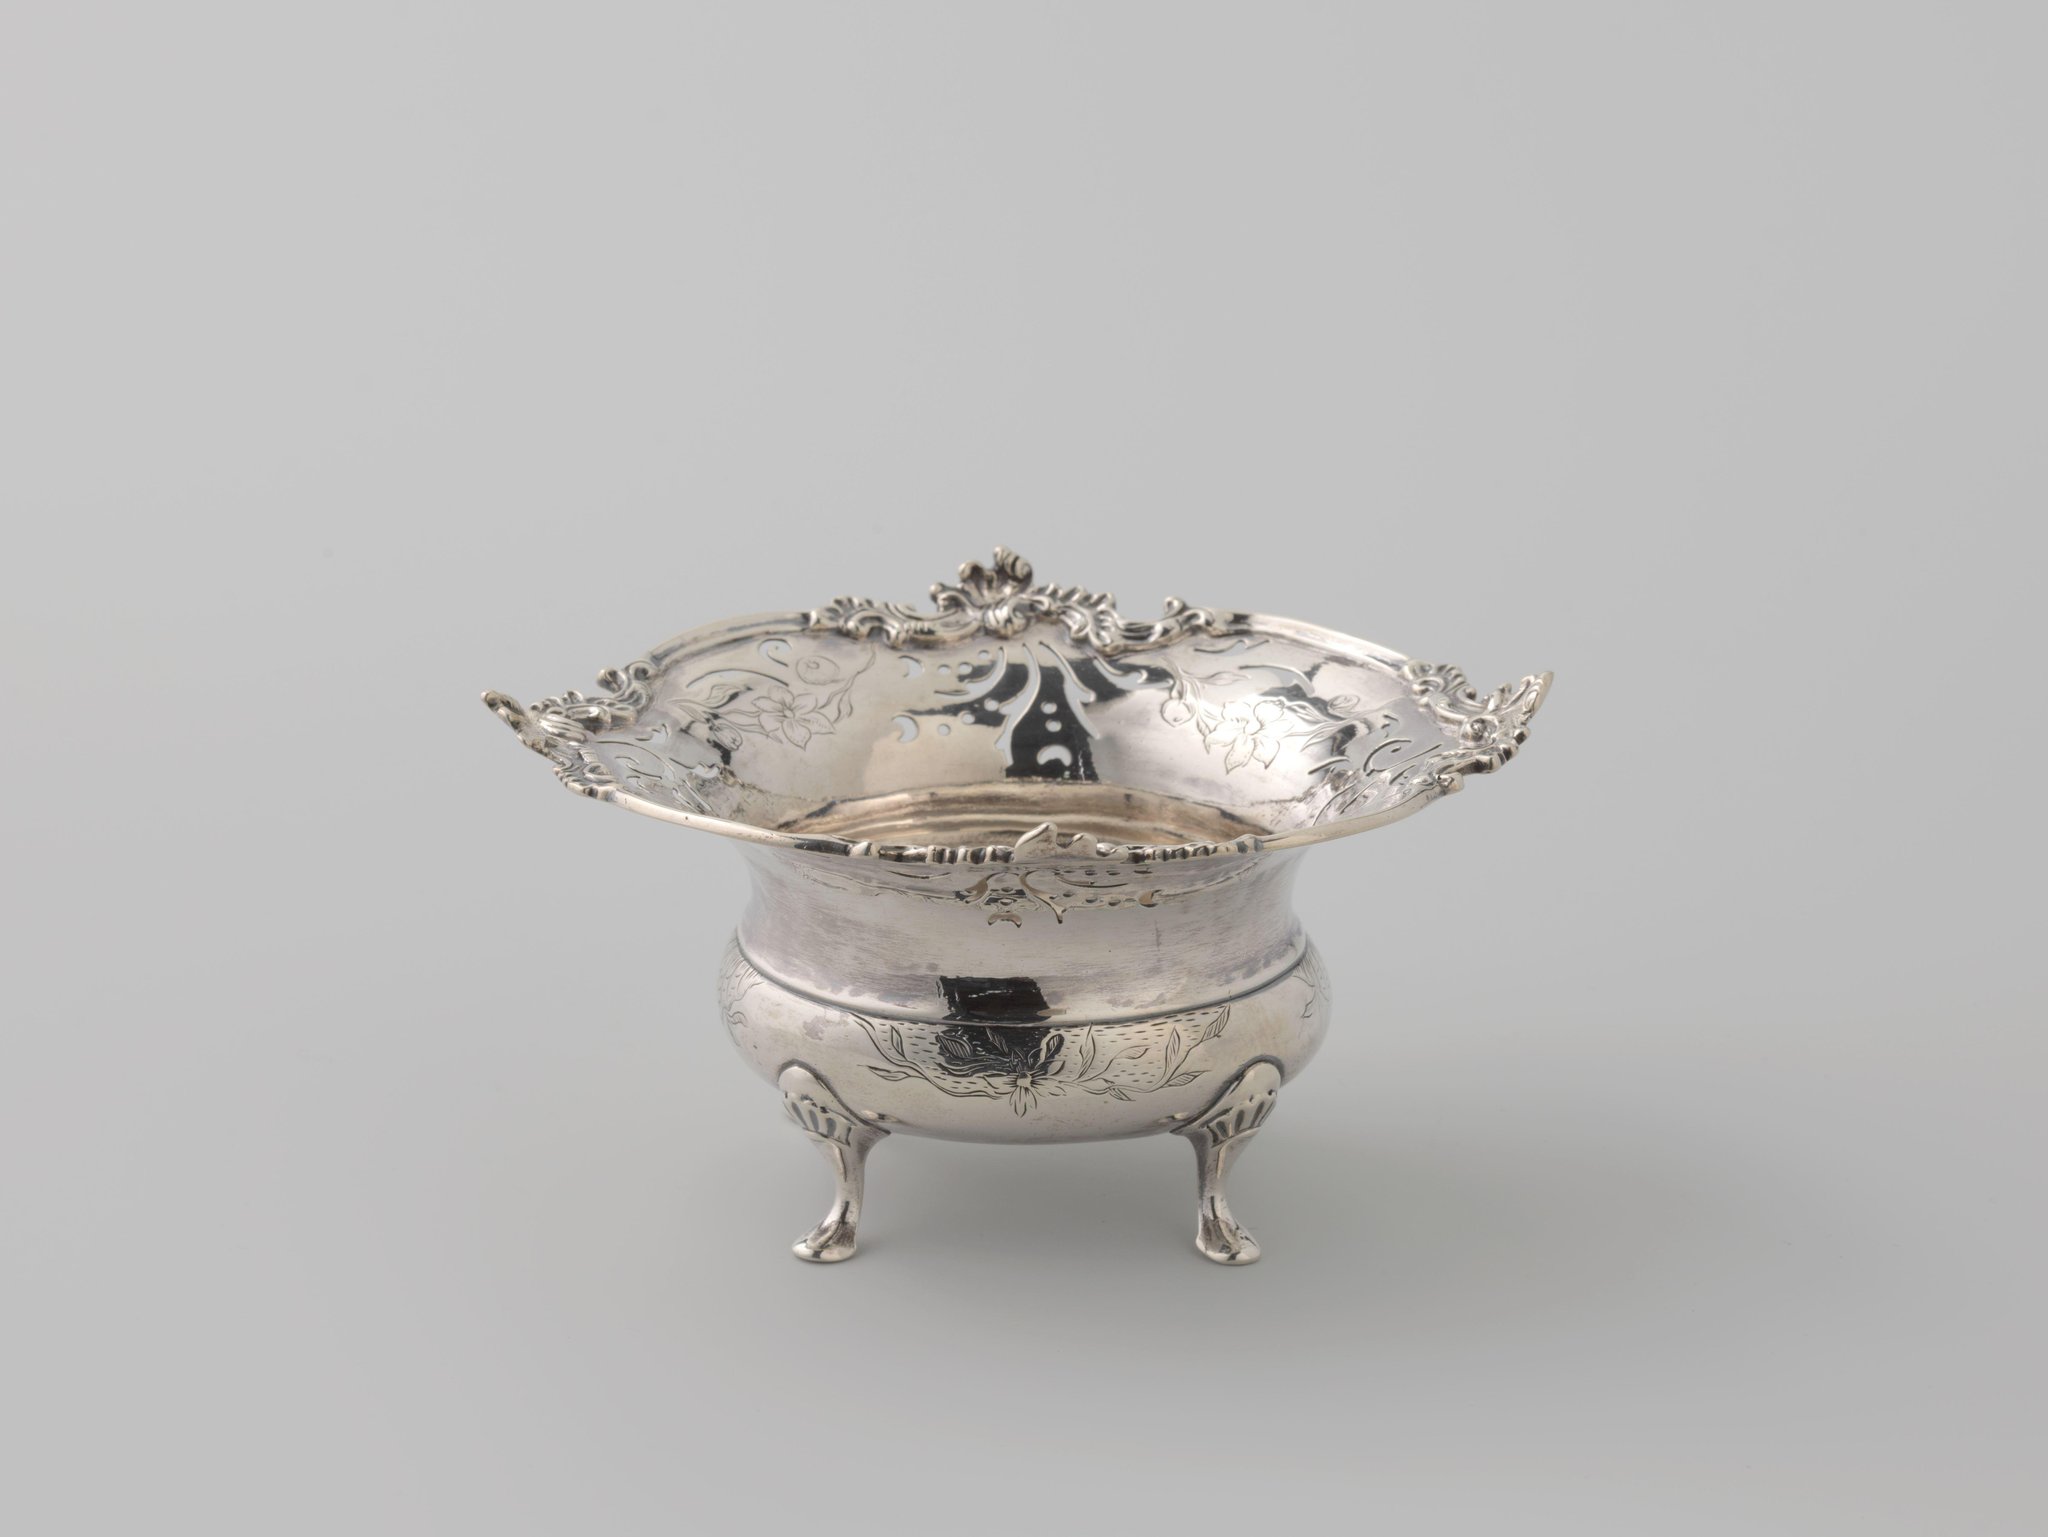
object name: kandijbak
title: Kandijbak in de vorm van een koelvat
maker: wijnand warneke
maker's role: silversmith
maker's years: 1738-1810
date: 1767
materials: silver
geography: amsterdam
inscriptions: maker's mark, alloy mark, date letter: ‘H’, duty mark, : ‘gekroonde O’, town mark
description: Kandijbak: het ovale bakje rust op vier gebogen pootjes die bij de aanzet geribbeld zijn. Het lichaam is opgebouwd uit een bolle buik en een gewelfd, zich verbredend bovengedeelte. In het midden van de korte en lange zijden van de aangezette bovenrand bevindt zich een ornament dat is opgebouwd uit c- en s-vormige voluten en een rocaille. Onder elk van deze ornamenten, is in het bovengedeelte van het lichaam een motief, bestaande uit voluten, kleine cirkels en halve maantjes, gezaagd. Hiertussen zijn van de bovenrand afhangende bloemkransen gegraveerd. Op de voor- en achterzijde van de buik is een bloem met aan weerszijden bladranken, en op de beide korte zijden van de buik een rocaille gegraveerd. vaal medaillon, voorstellingen gegraveerd van staande vrouwenfiguren met Opmerking: het lijkt alsof de maker het kandijbakje als een verkleinde versie van het koelvat heeft vormgegeven.